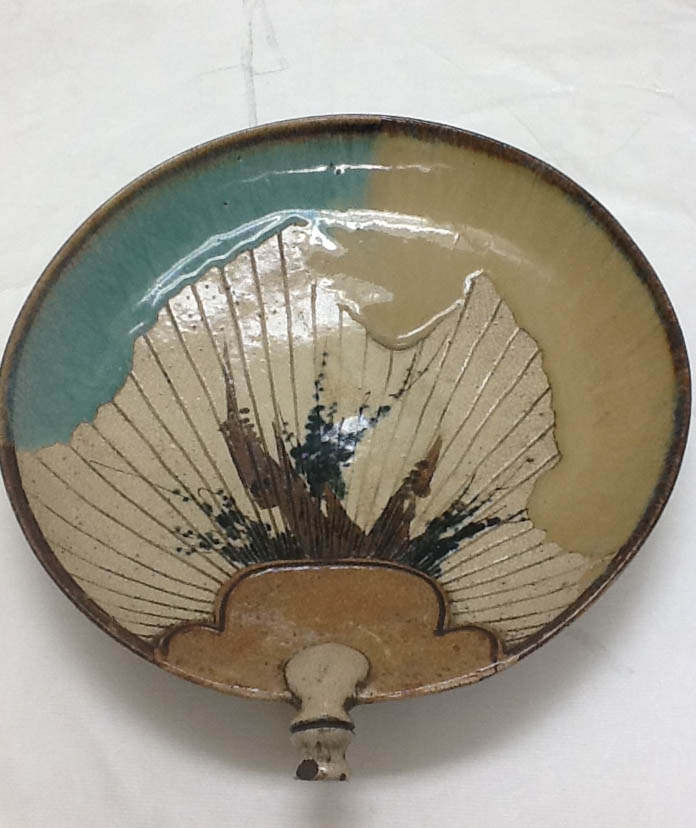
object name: dish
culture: japanese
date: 1801-1900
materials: clay, glaze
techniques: drawing